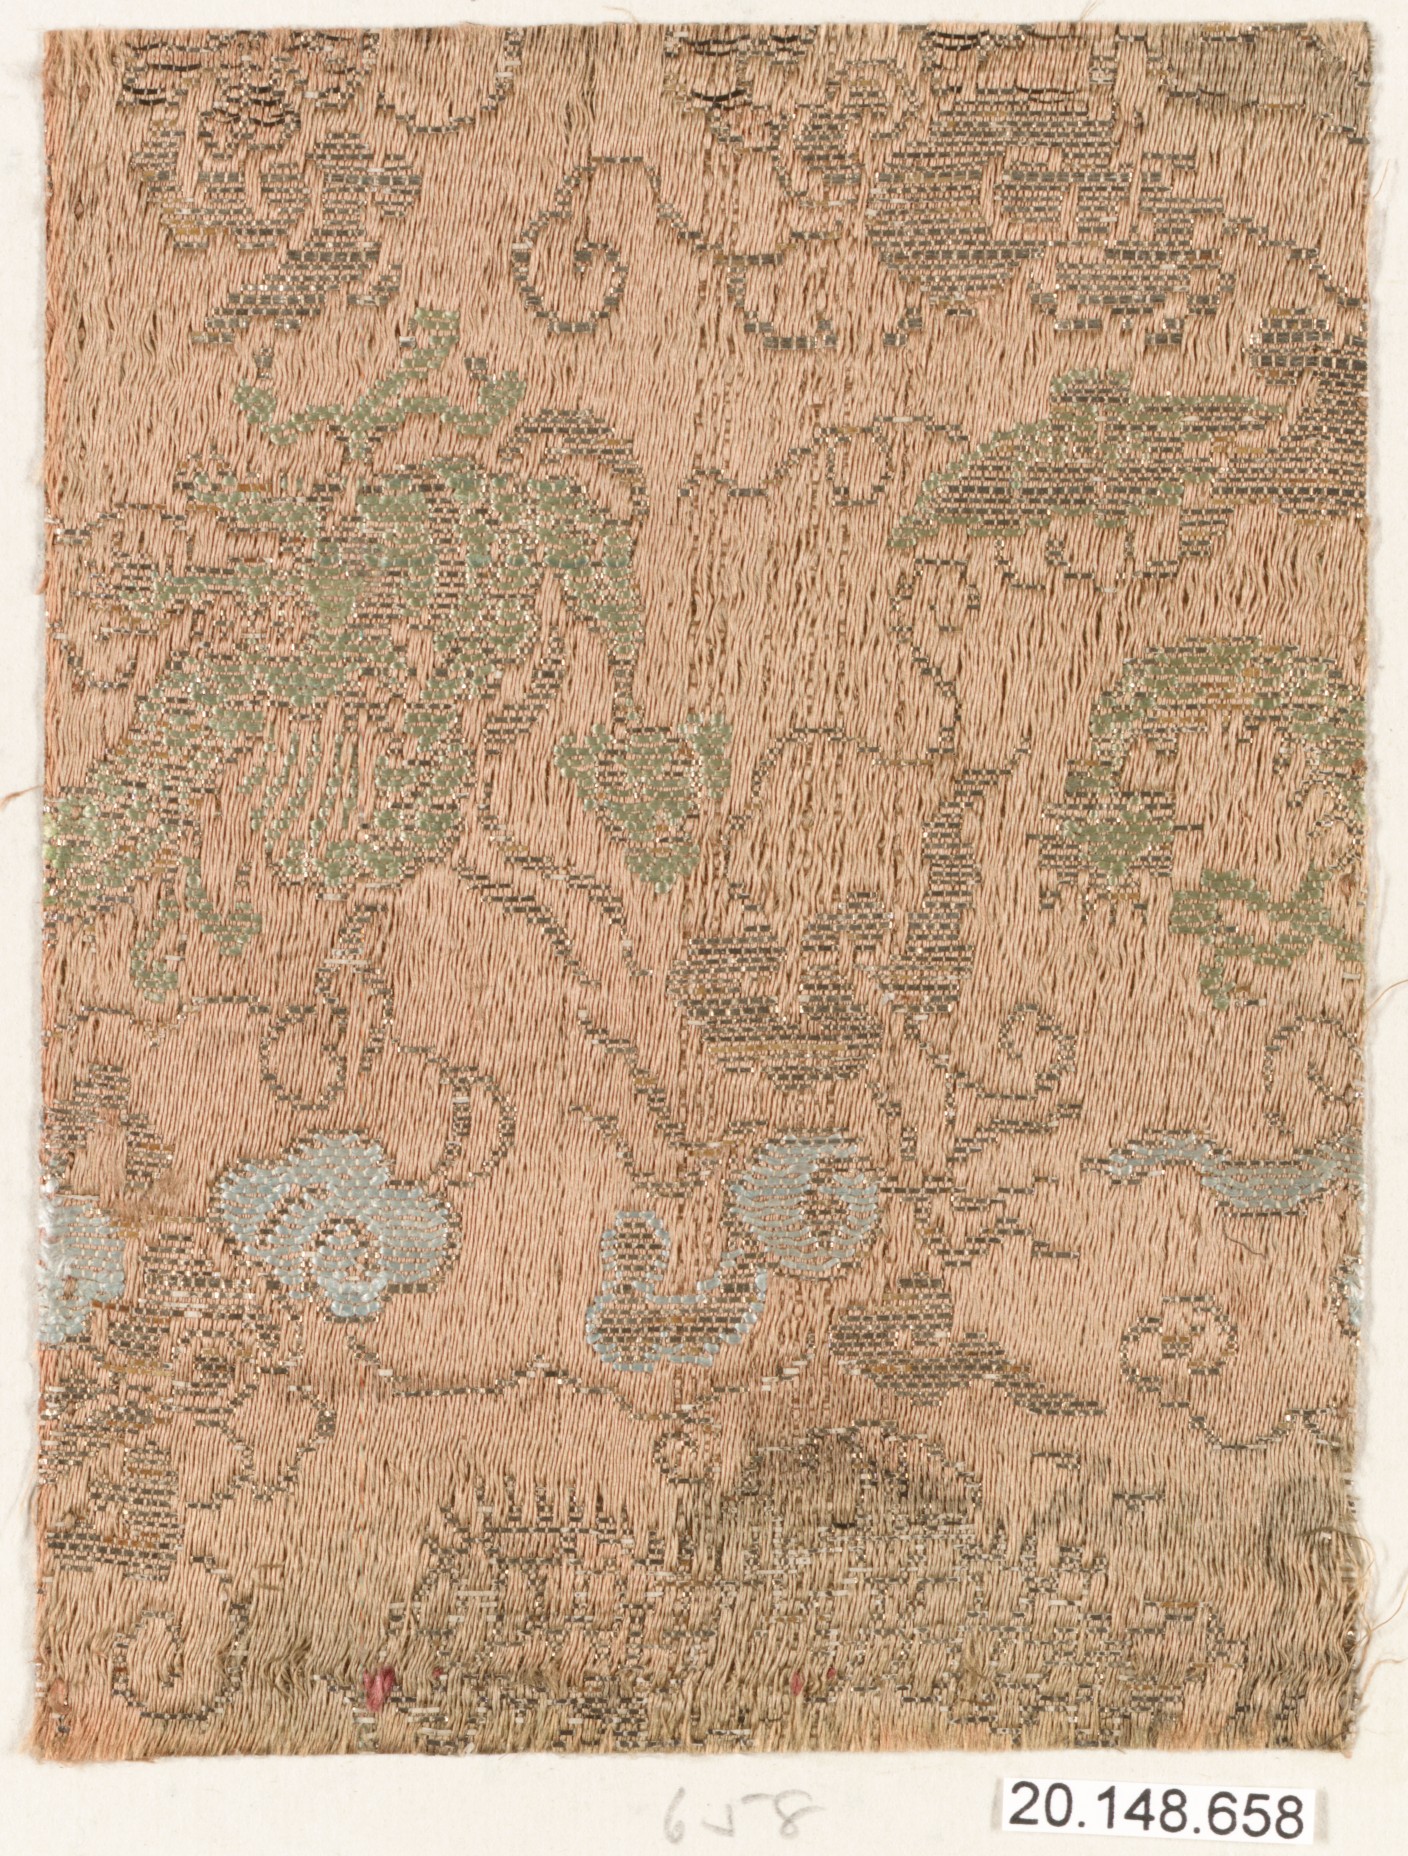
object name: piece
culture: japanese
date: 1601-1700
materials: silk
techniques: compound weave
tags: flowers